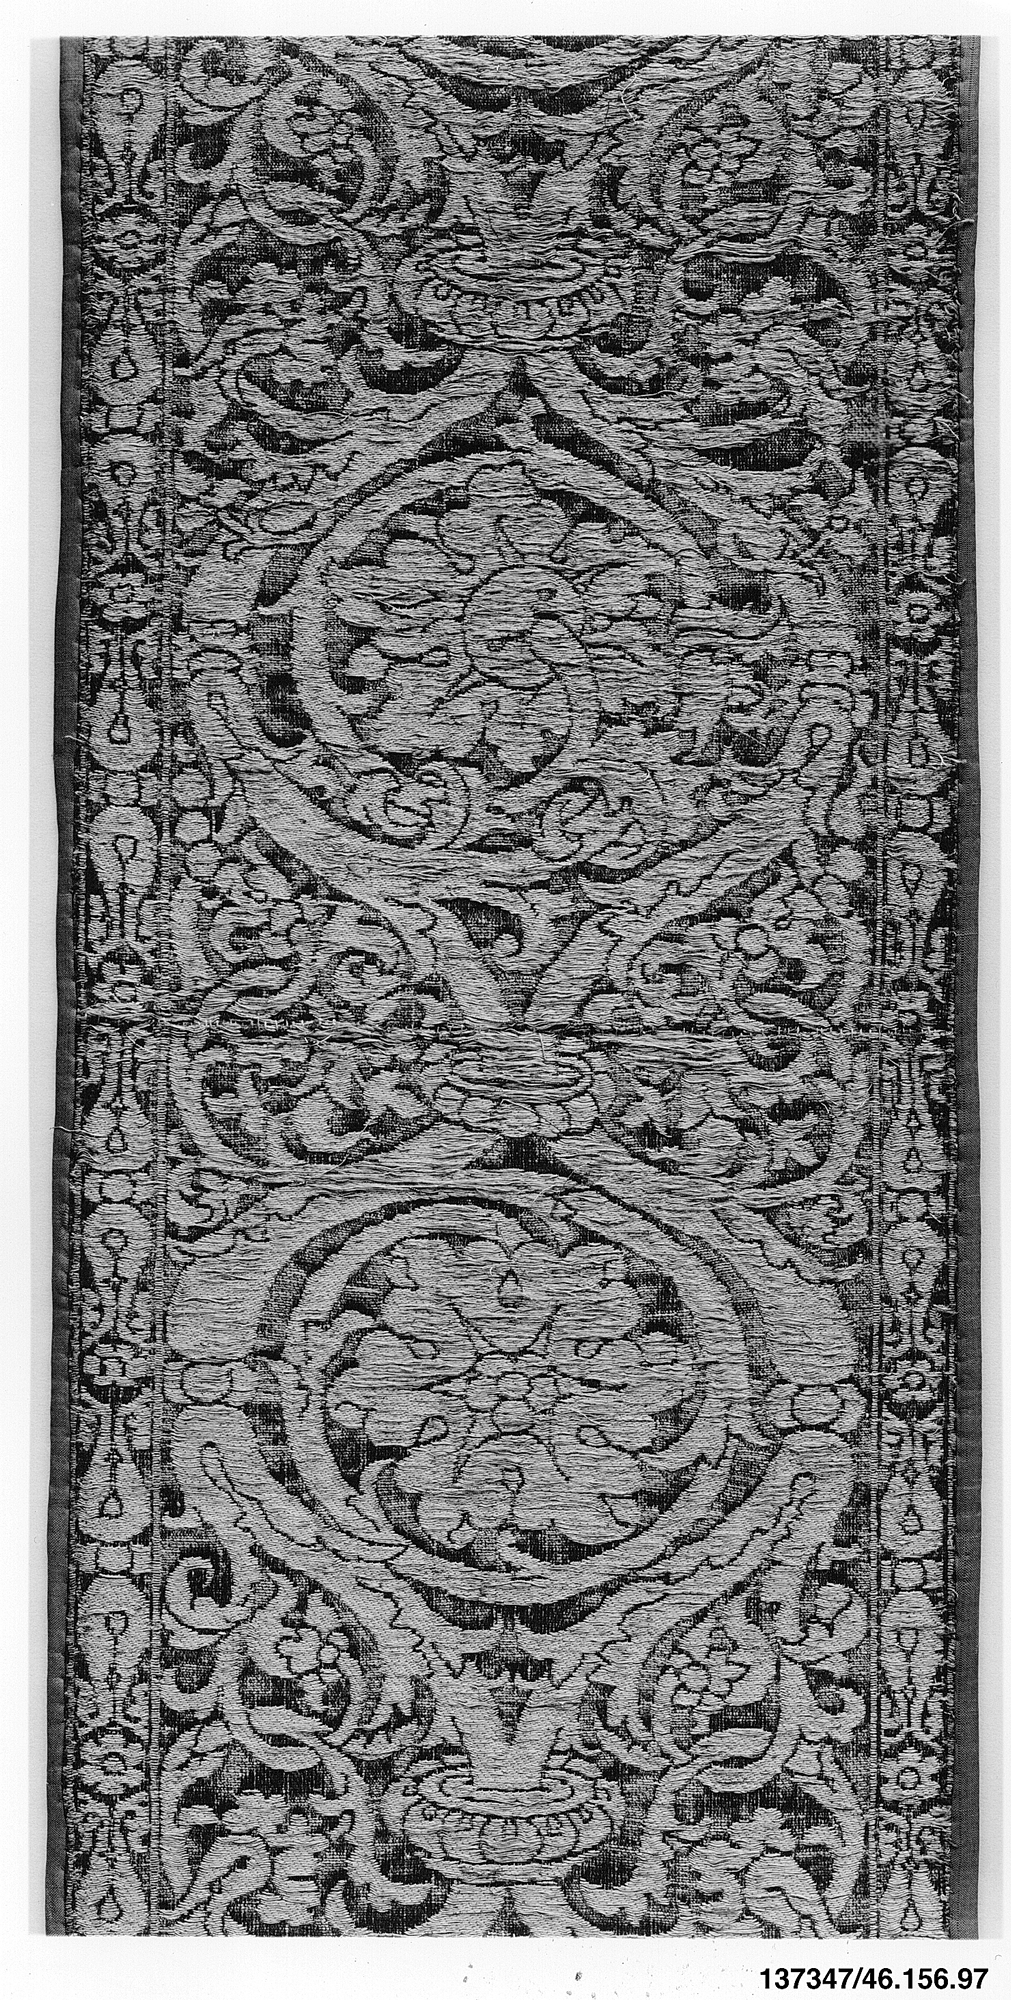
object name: band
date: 1501-1550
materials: linen, metal thread, silk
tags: flowers